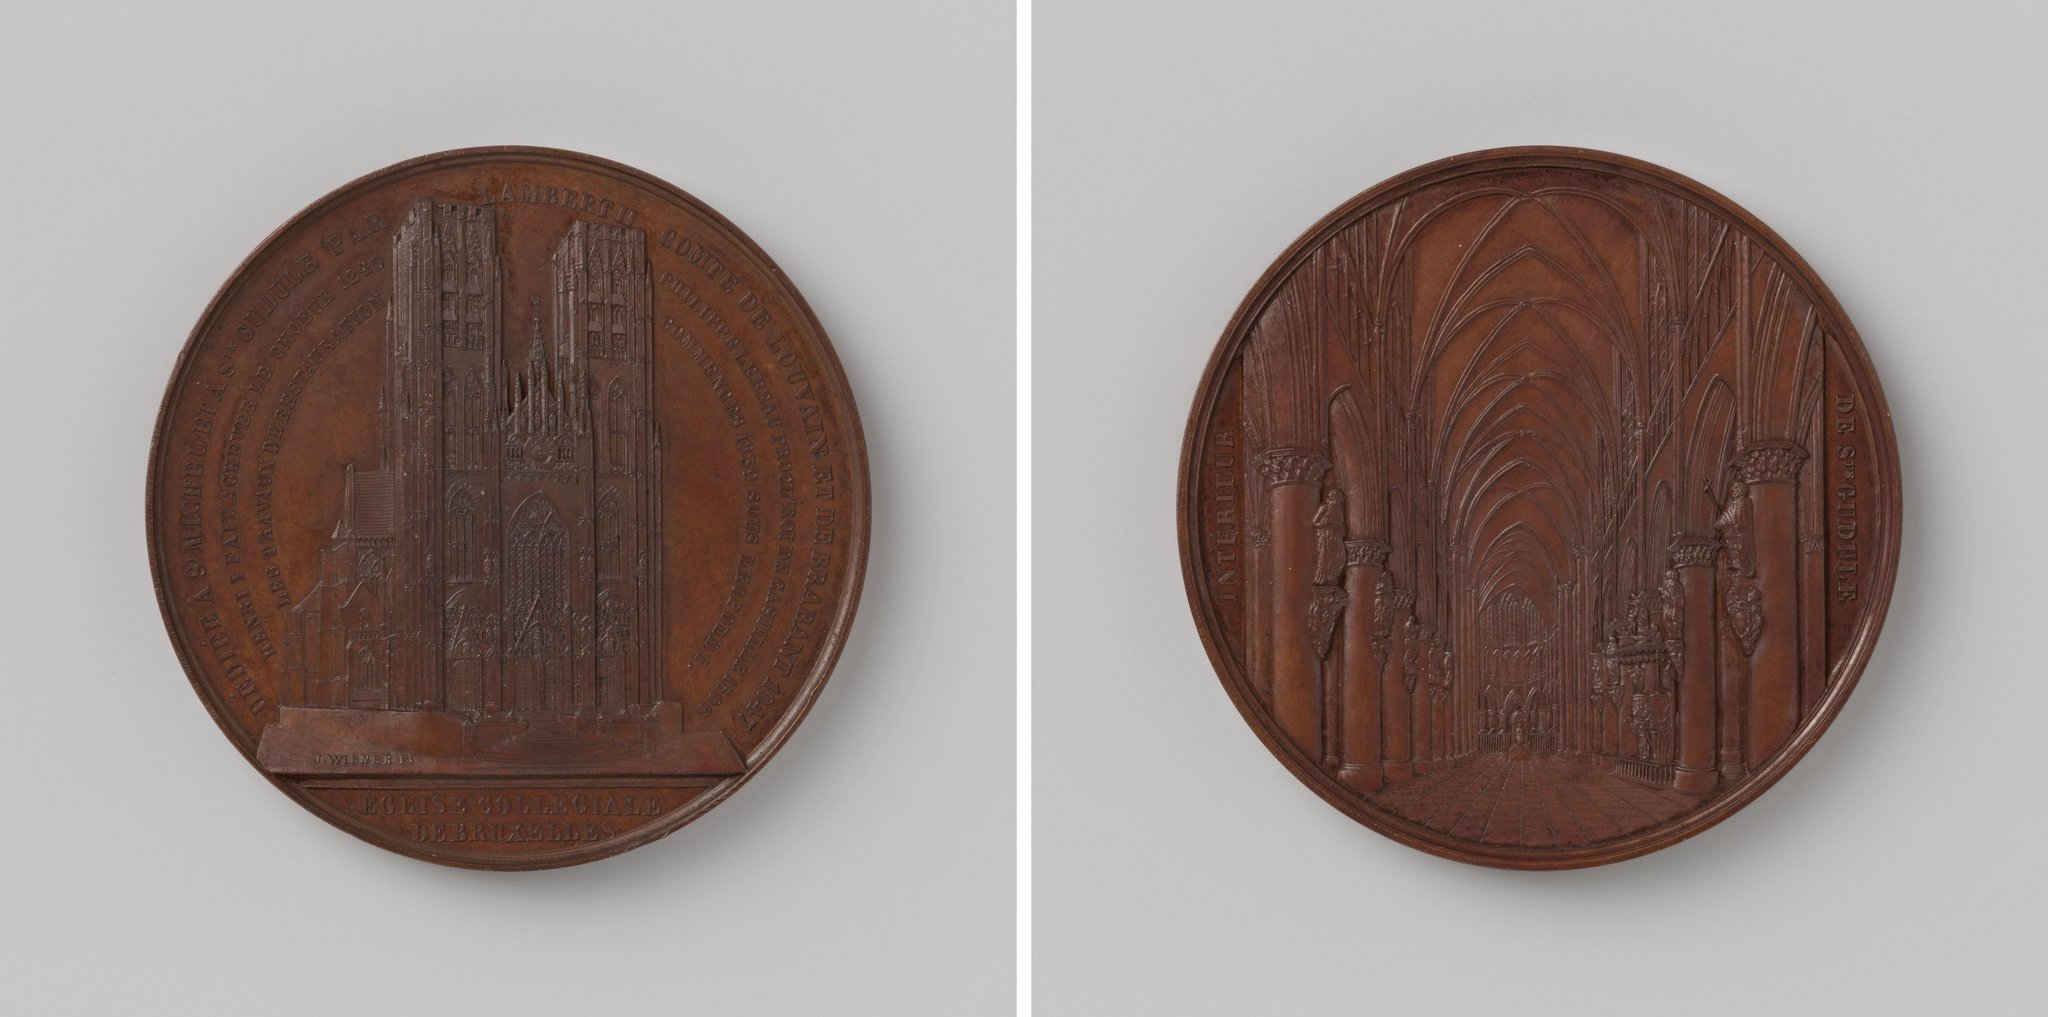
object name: history medal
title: Collegiale kerk van St. Michel en St. Gudule te Brussel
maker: jacob wiener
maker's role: medailleur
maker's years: 1815-1899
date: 1845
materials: bronze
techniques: striking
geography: brussels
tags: sint-michiel en sint-goedelekathedraal